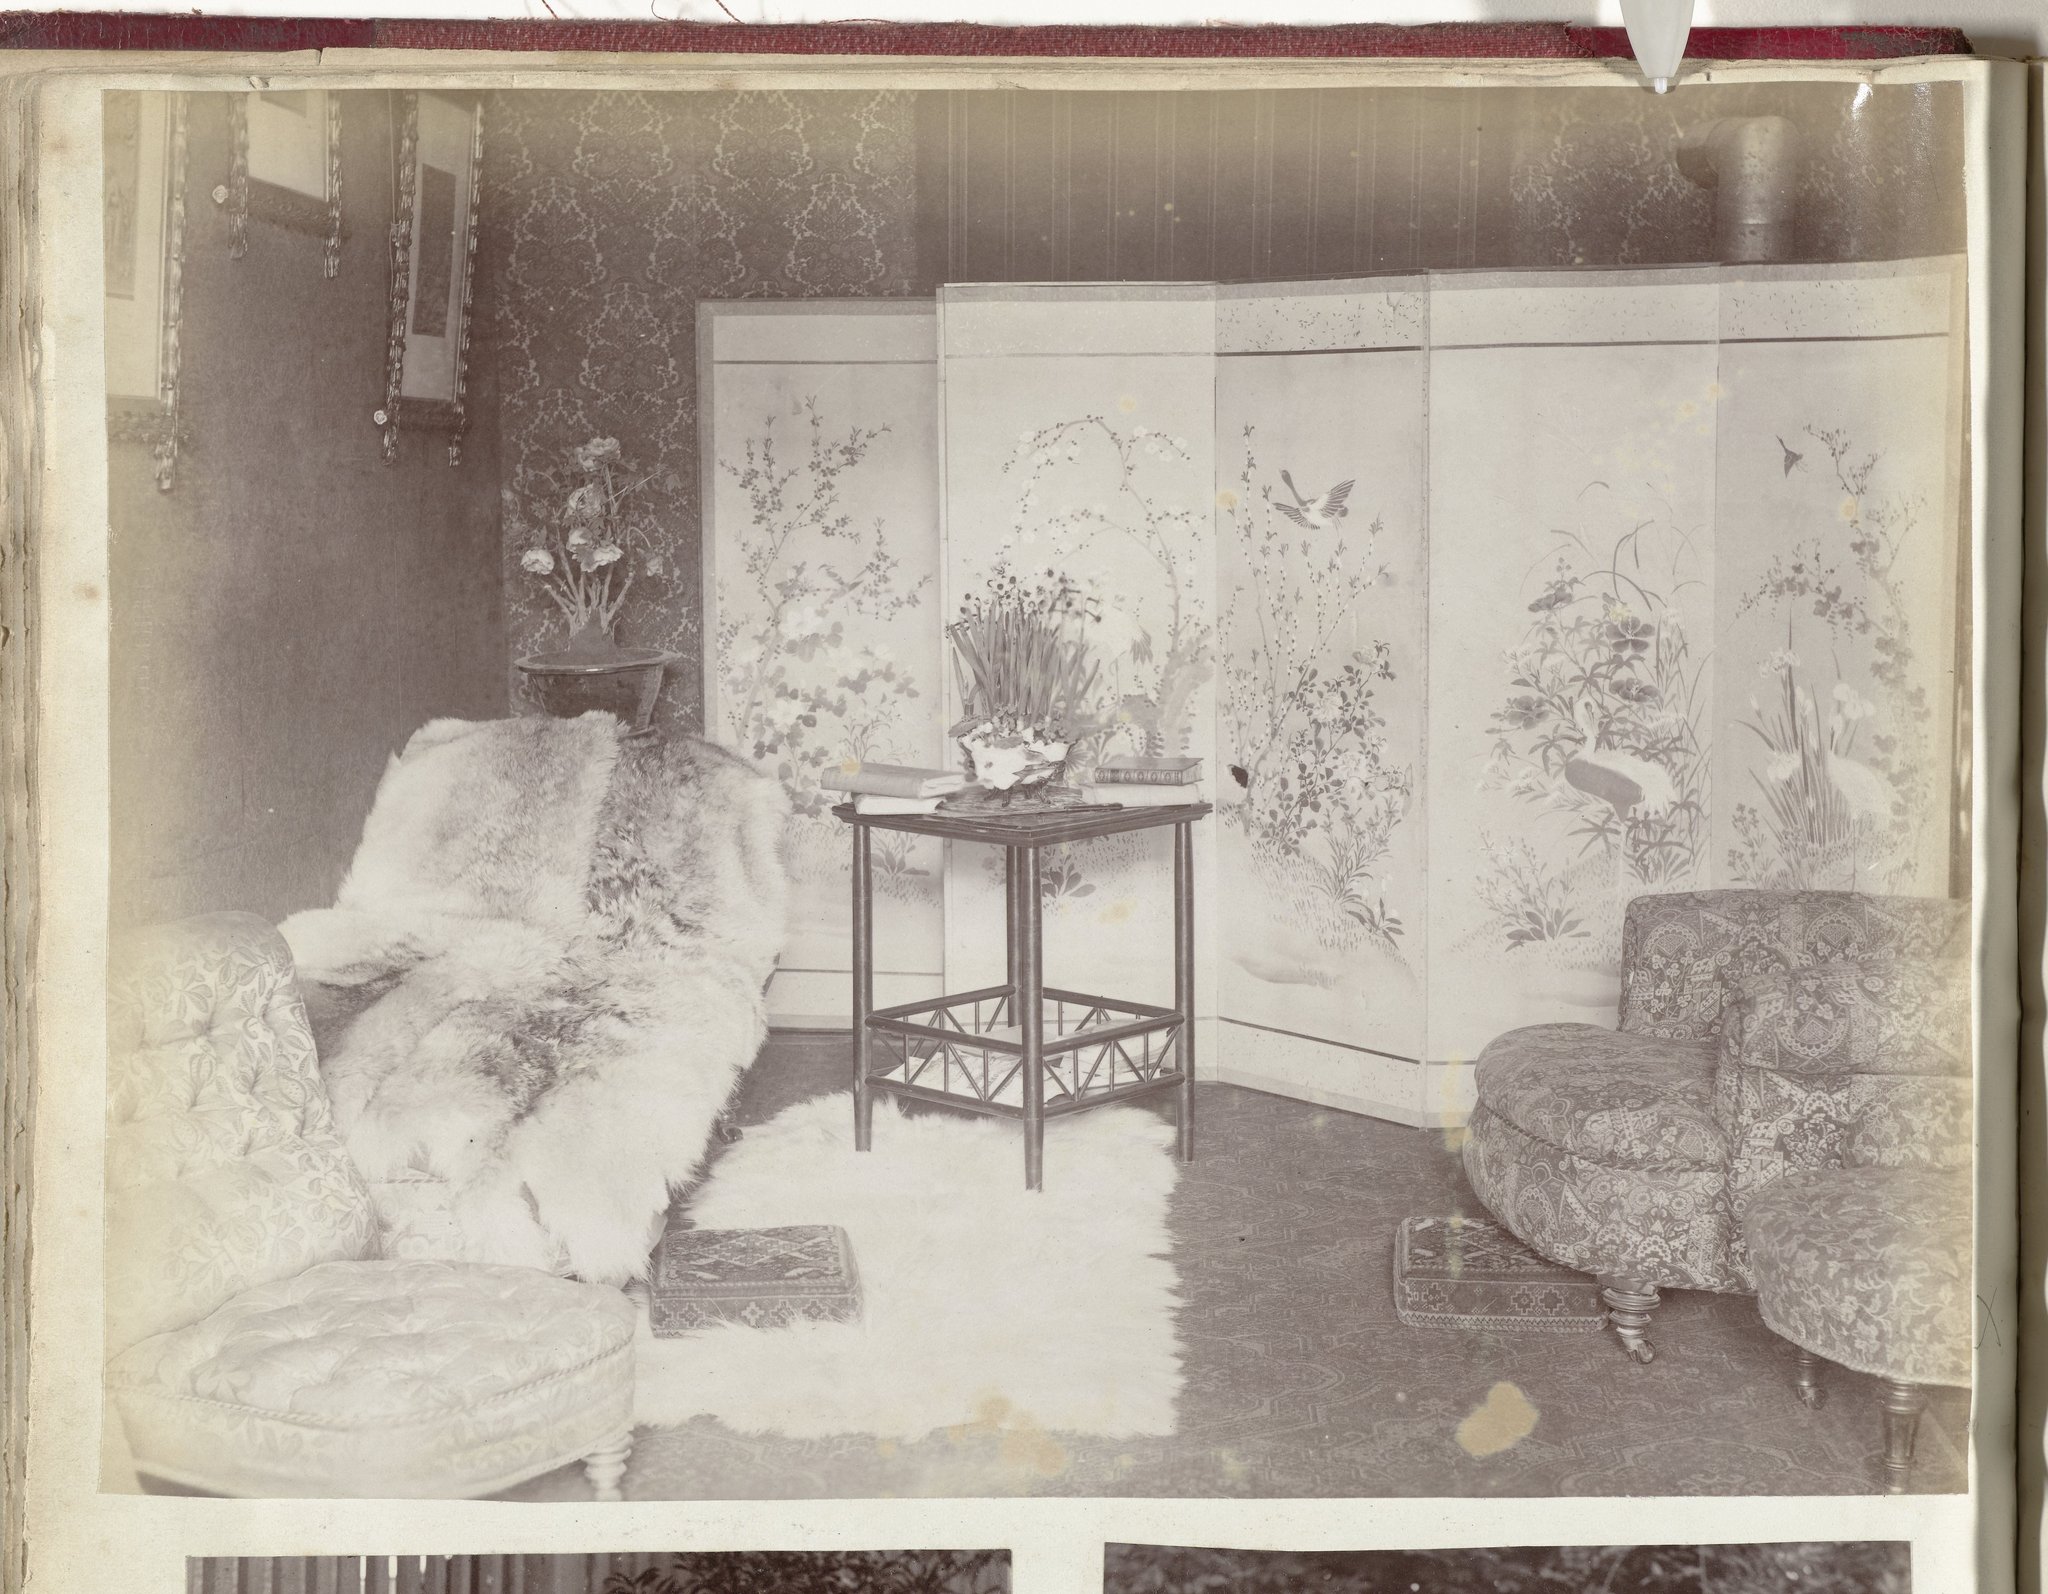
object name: album leaf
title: Interieur met kamerscherm, bijzettafels en stoelen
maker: Anonymous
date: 1879-1890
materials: paper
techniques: albumen print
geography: china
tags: screen, folding screen, chair, china